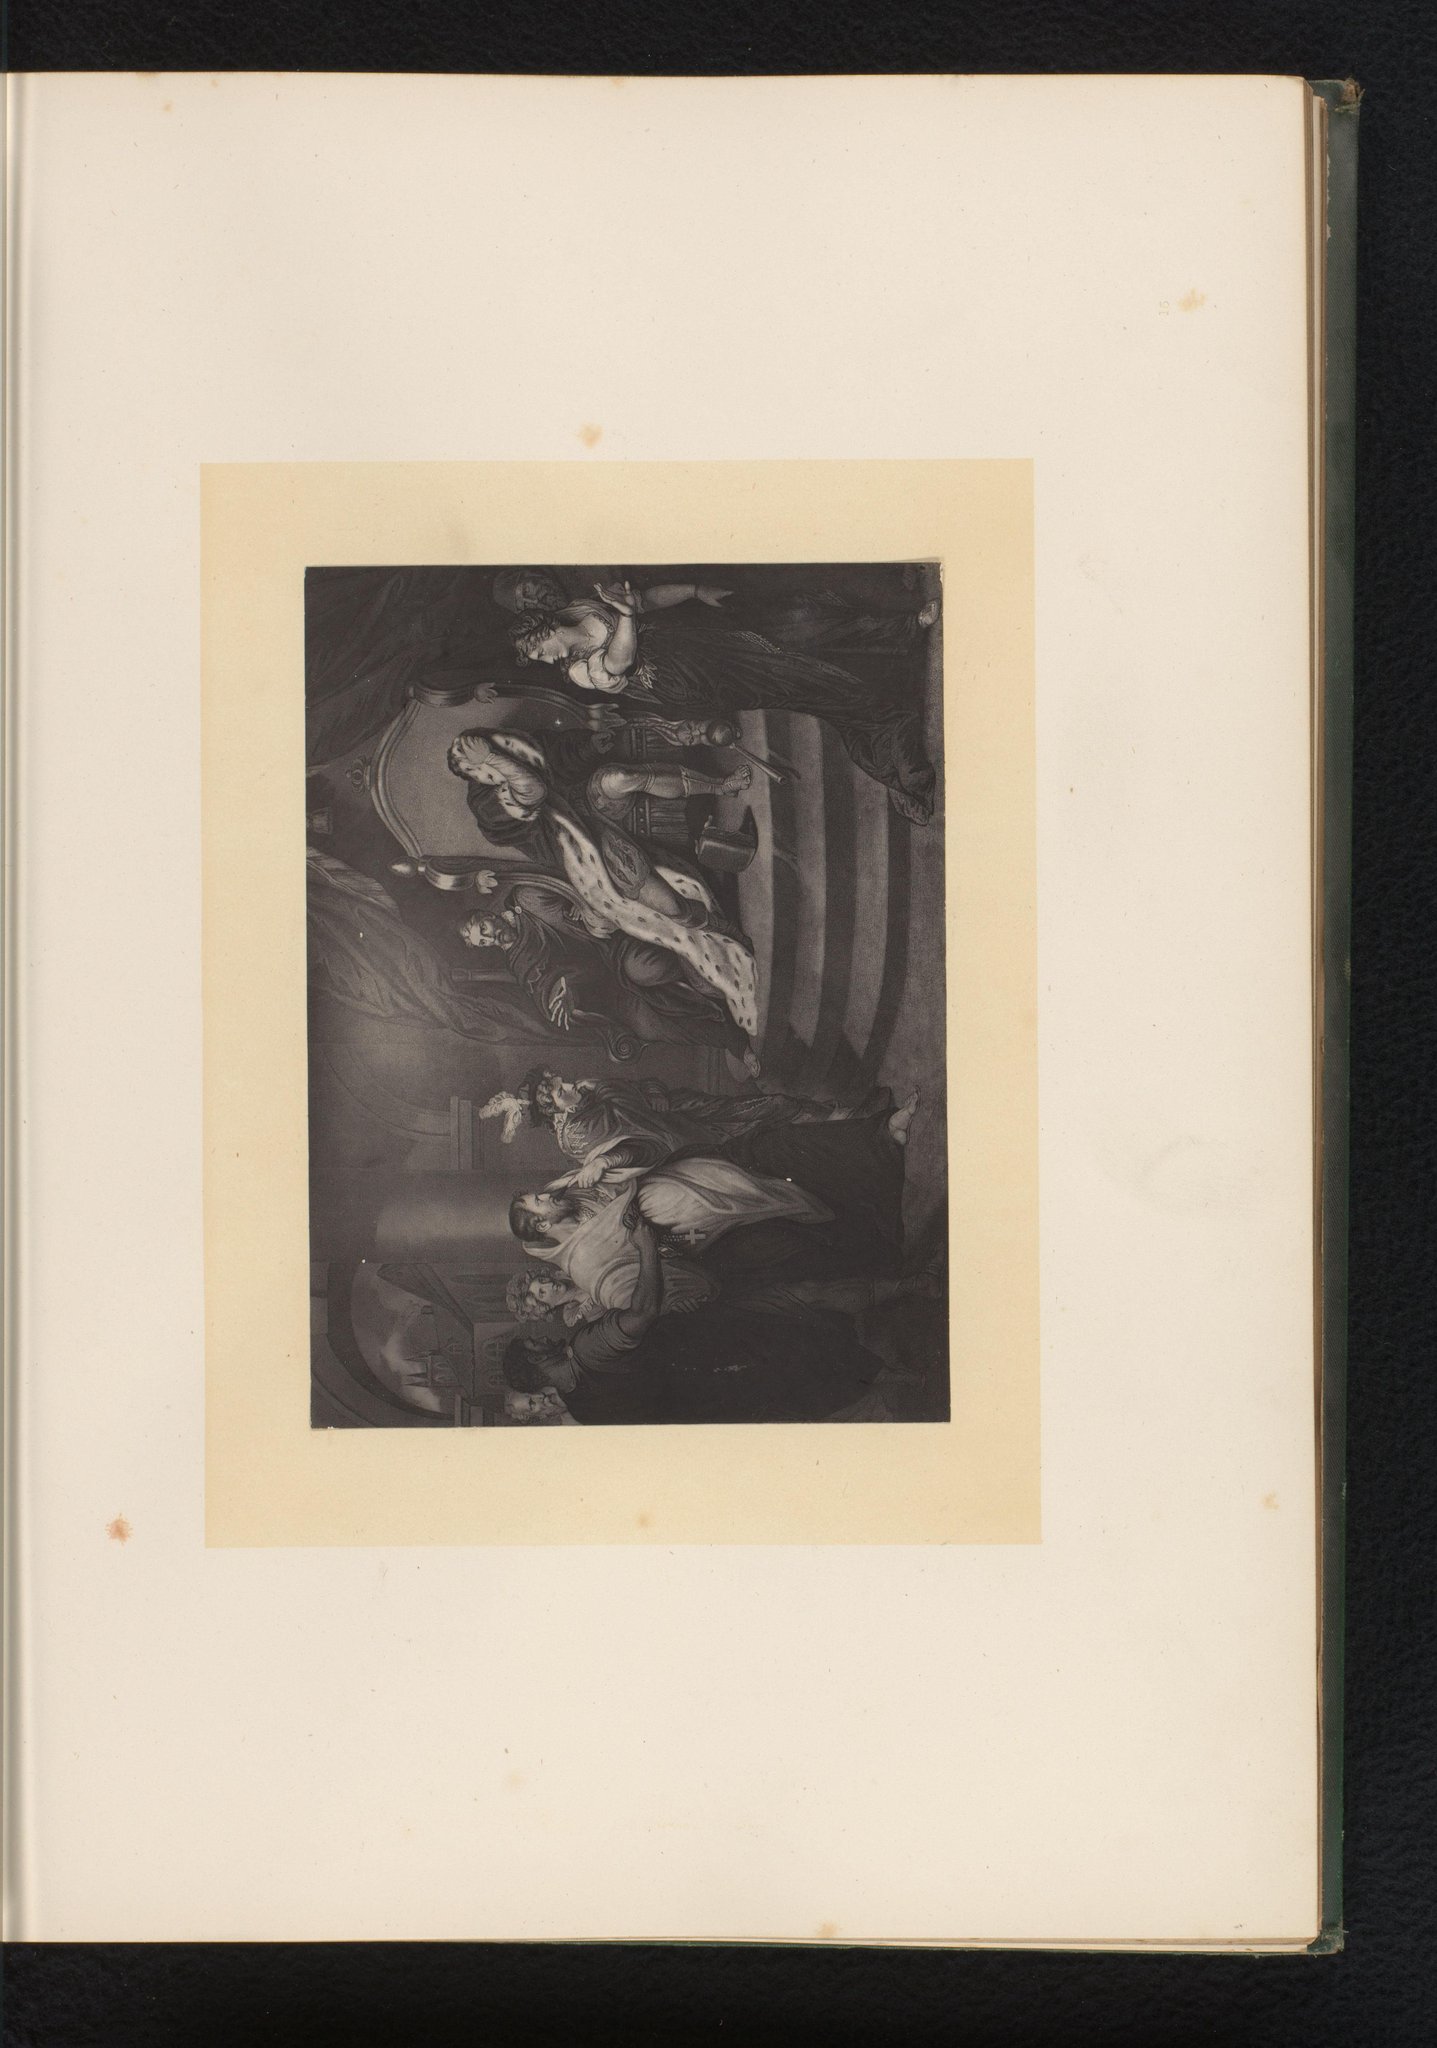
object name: reproduction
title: Reproductie van een gravure naar een schilderij van een scène uit Measure for Measure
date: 1874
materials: paper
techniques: woodburytype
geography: london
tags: comedy